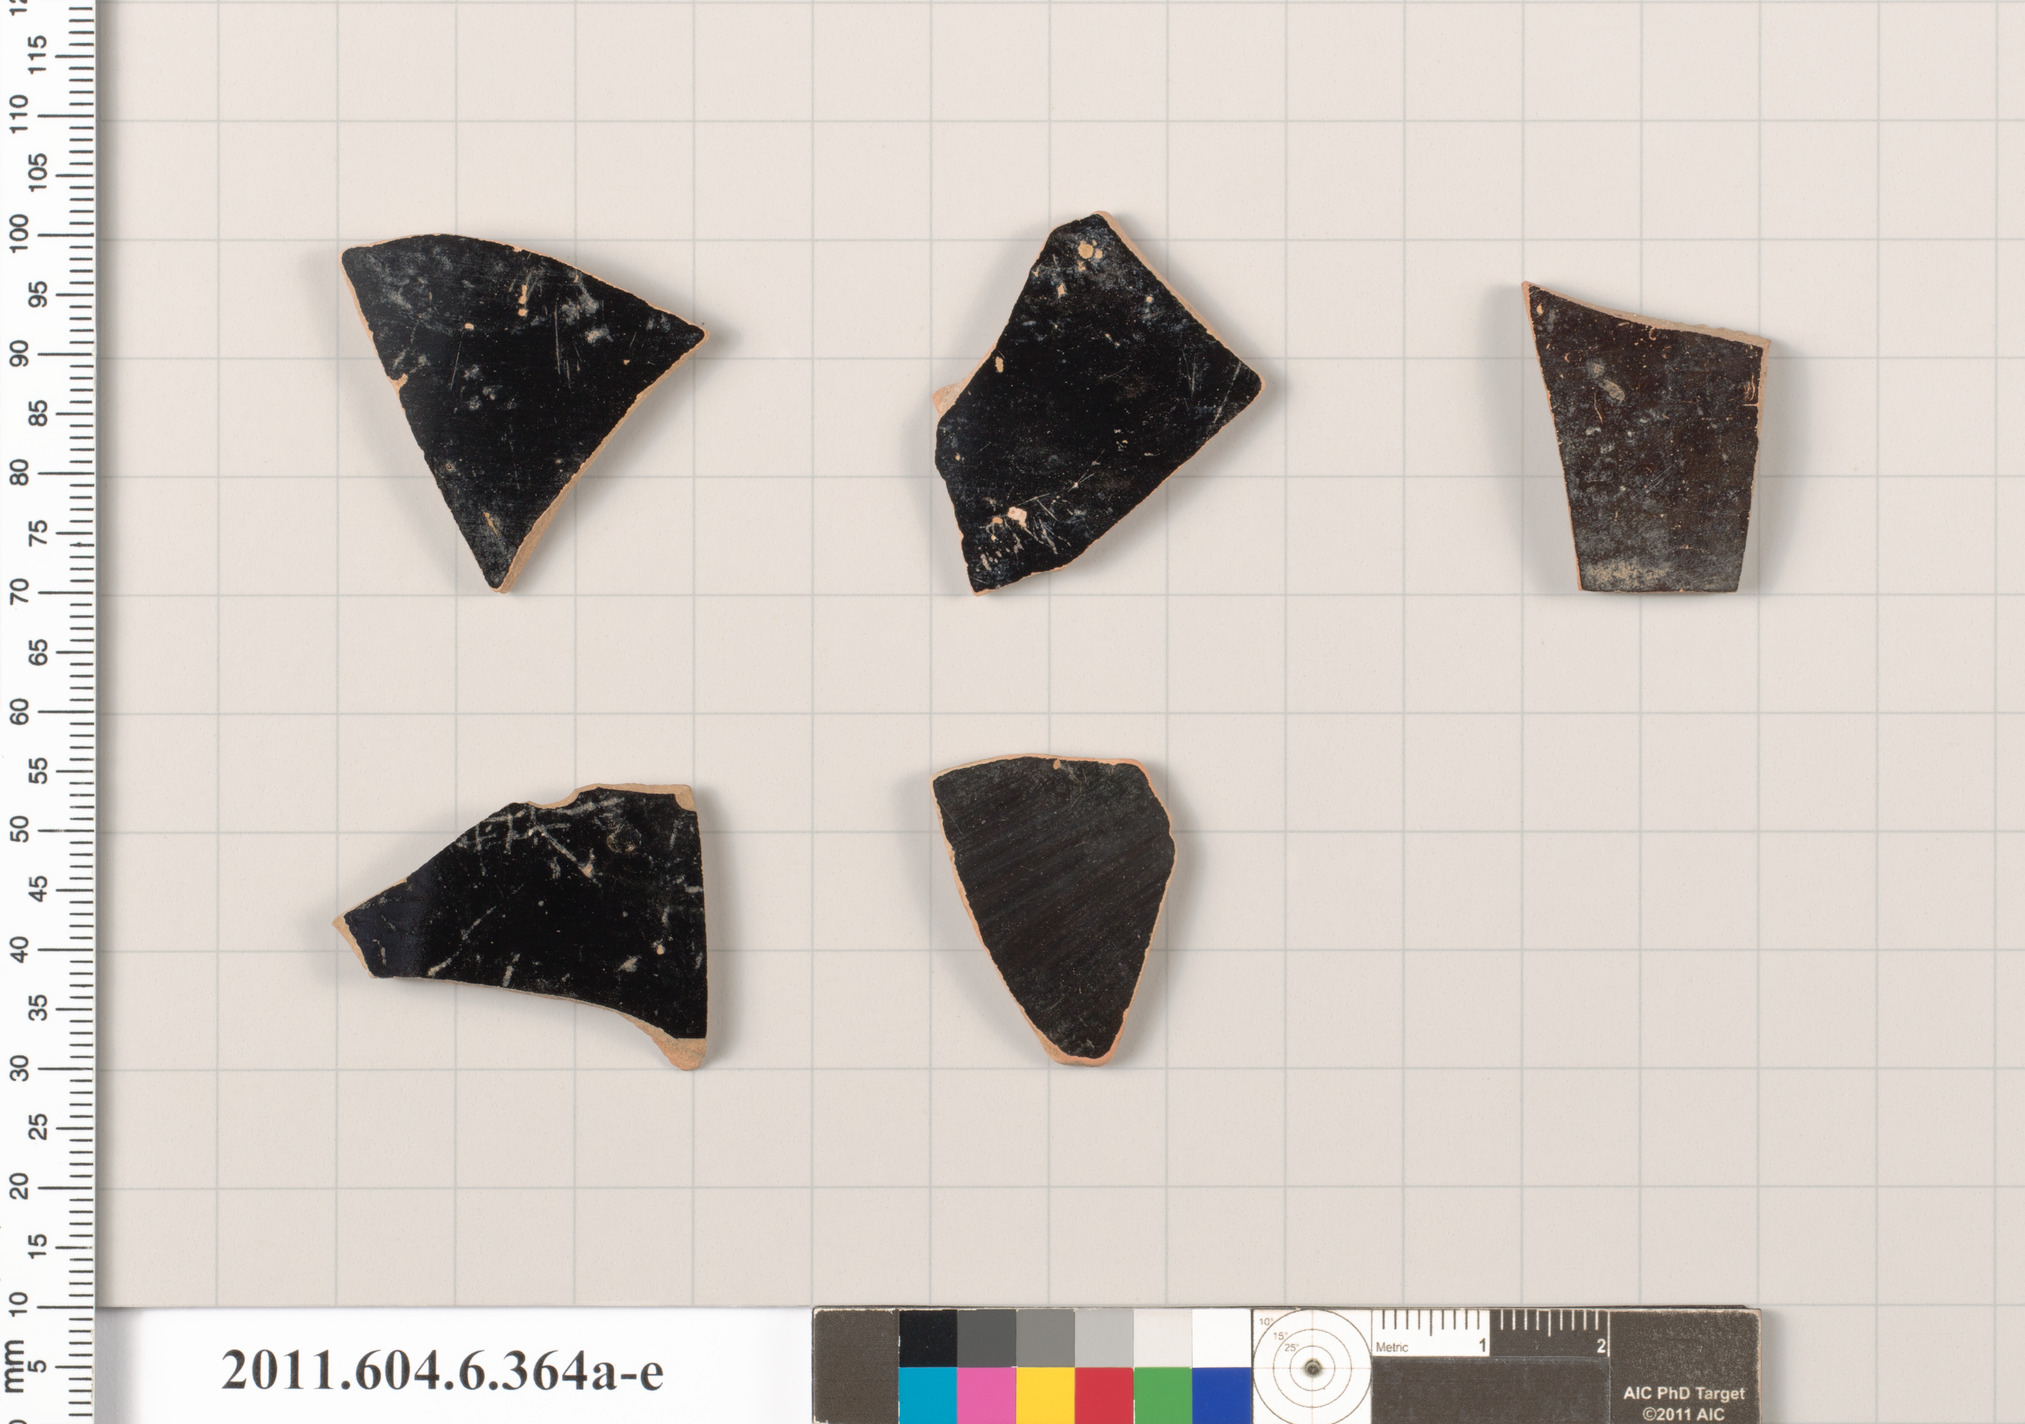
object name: undetermined closed shape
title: Terracotta fragments of closed shapes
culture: greek, attic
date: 600-401 BCE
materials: terracotta